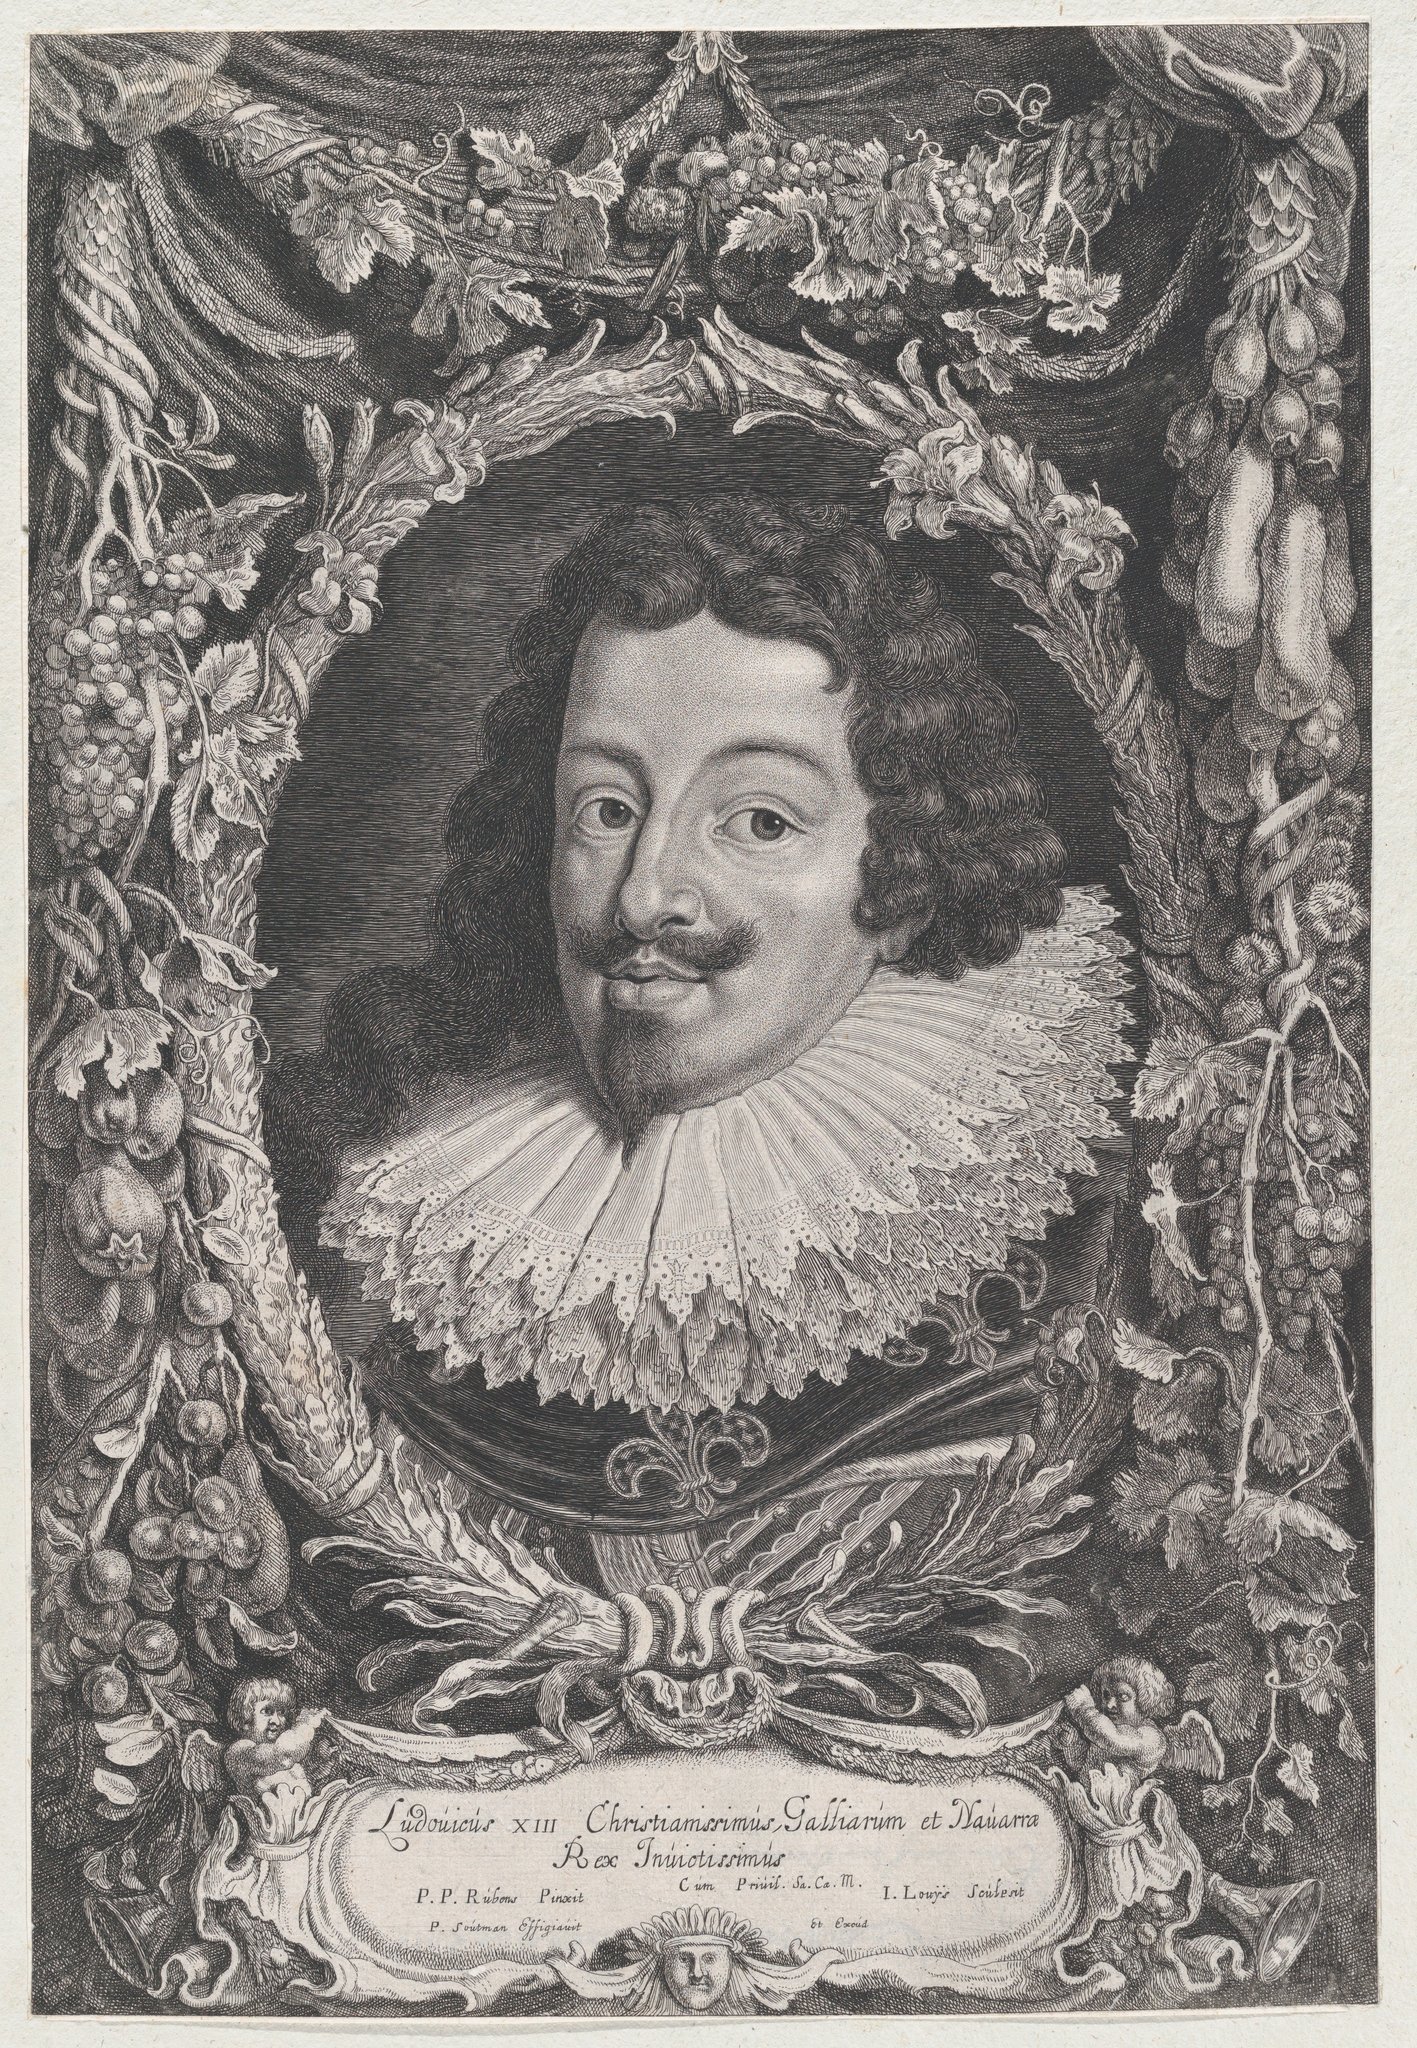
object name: print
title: Portrait of Louis XIII, King of France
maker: jacob louys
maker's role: artist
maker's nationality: dutch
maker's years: 1595-1673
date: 1650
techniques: engraving, etching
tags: kings,men,portraits